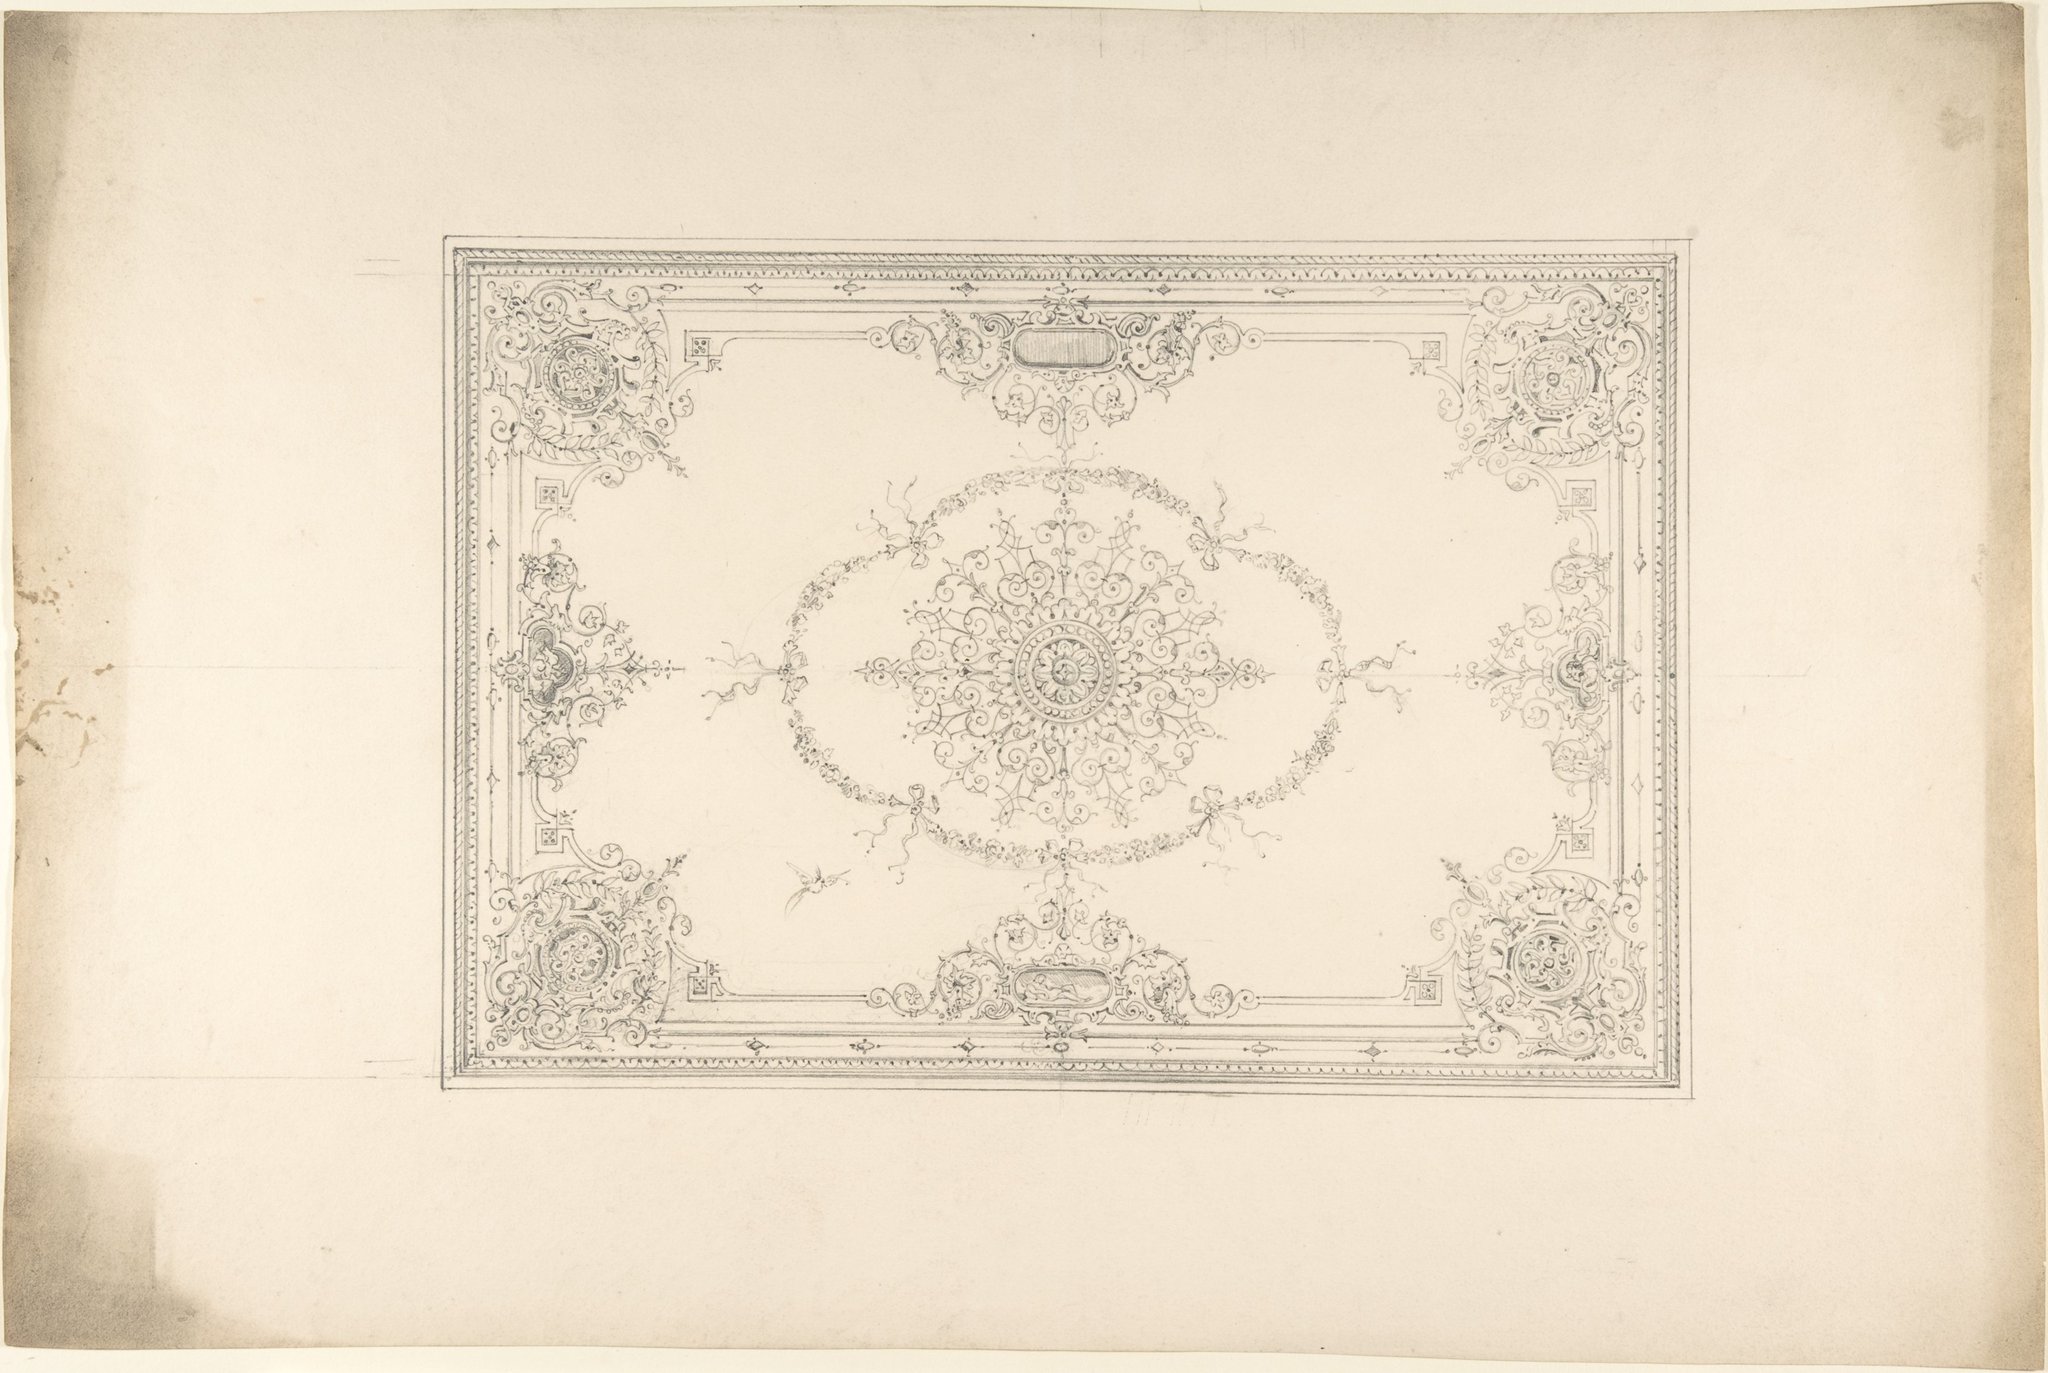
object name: drawing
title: Rococo Style Ceiling Design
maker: john gregory crace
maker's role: artist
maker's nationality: british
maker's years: 1809-1889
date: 1801-1900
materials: graphite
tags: ceilings